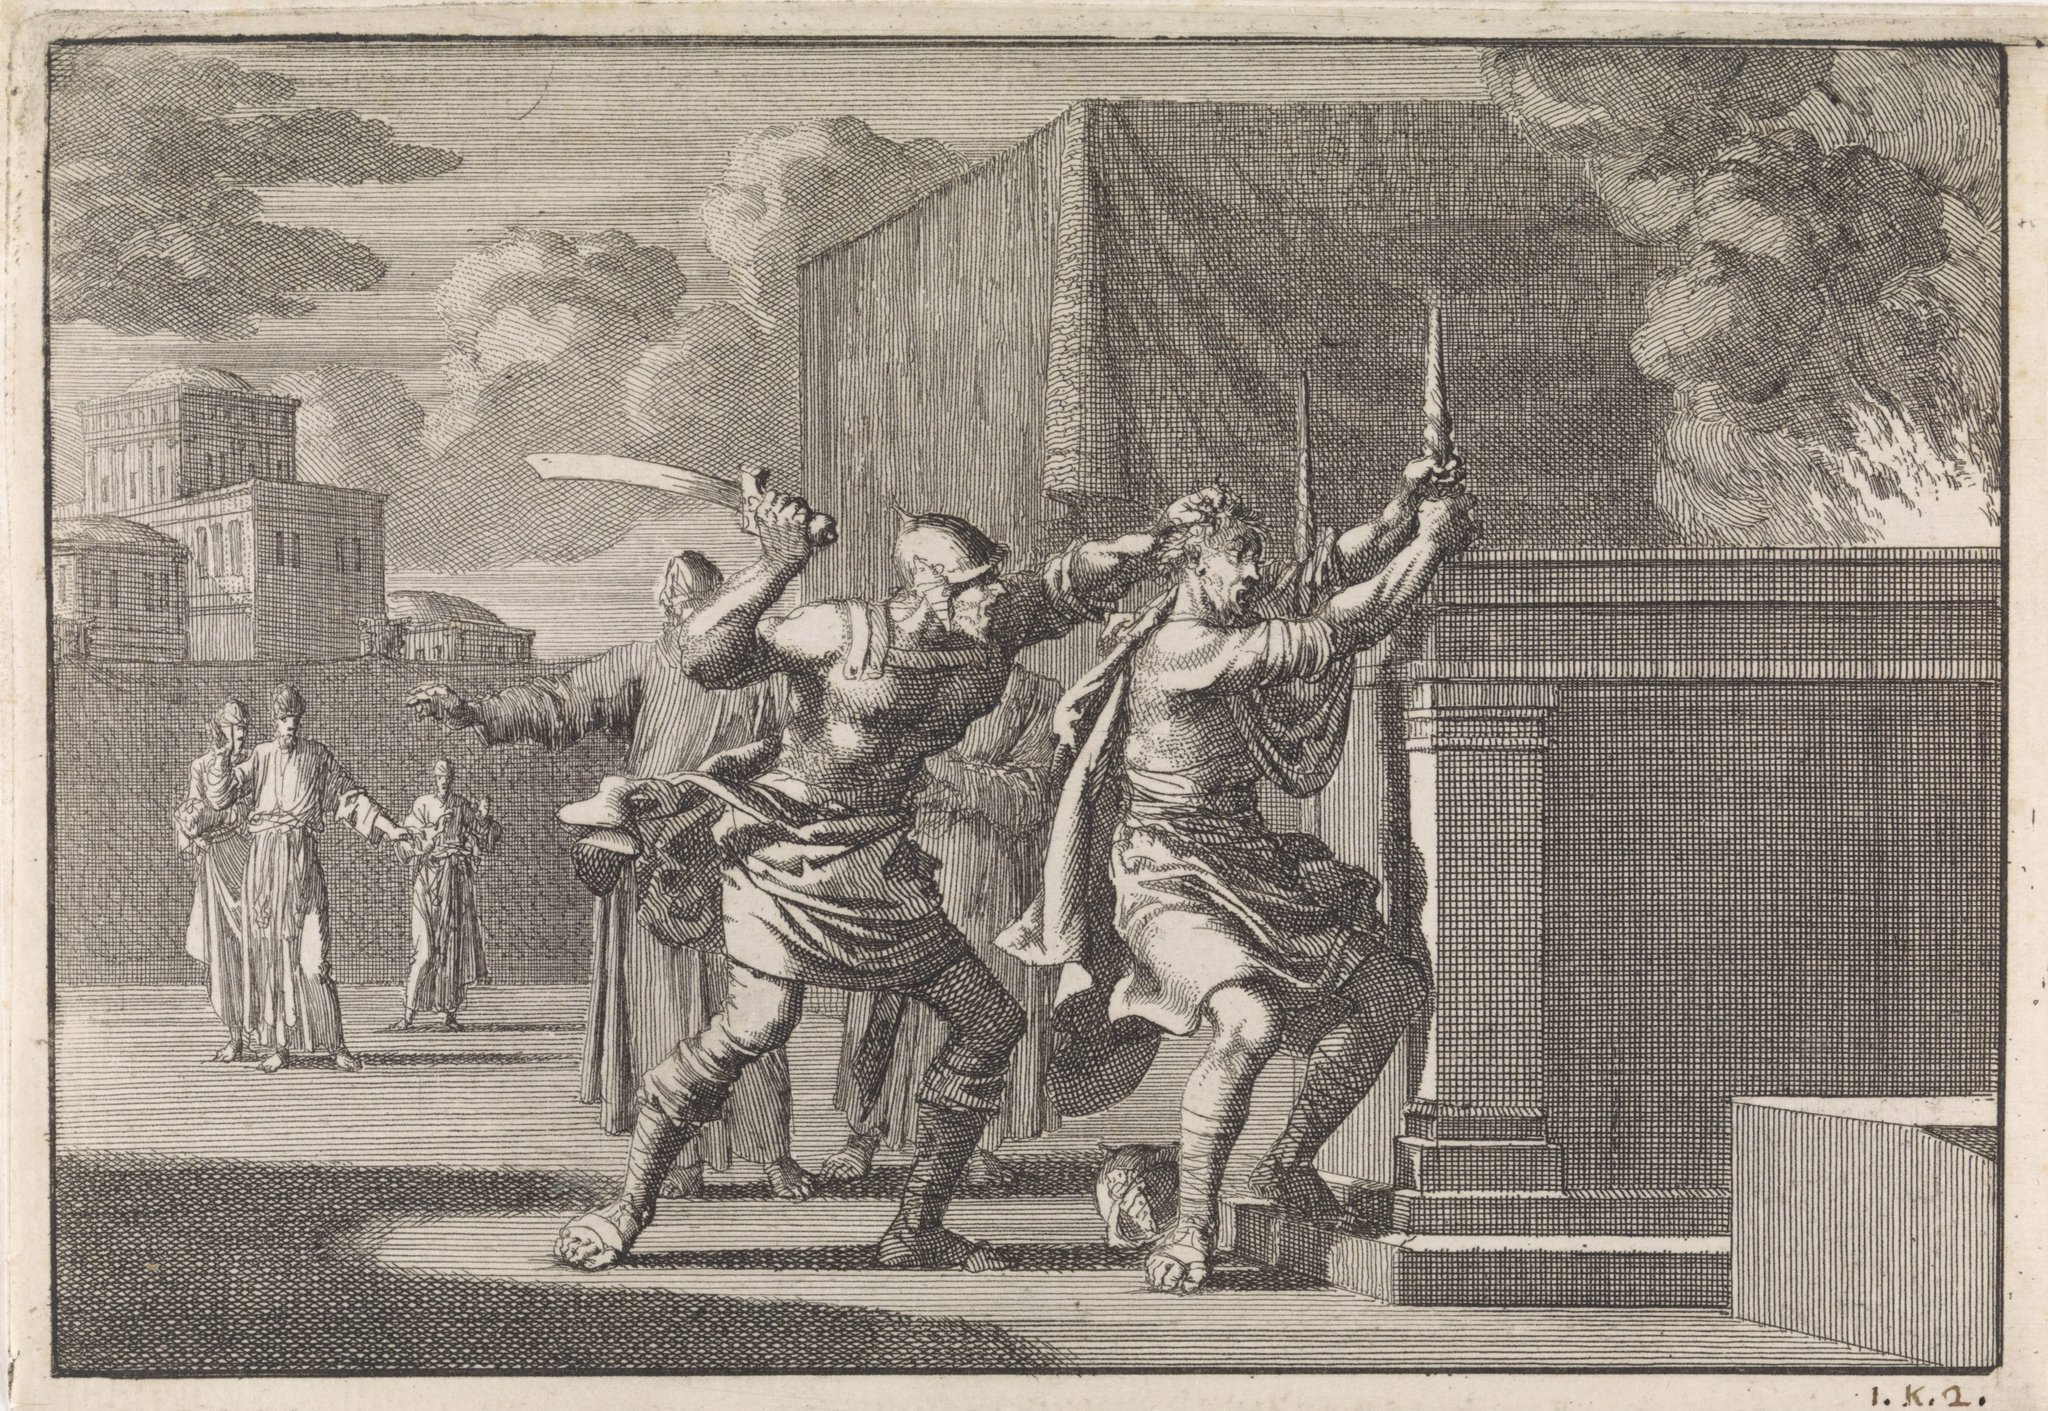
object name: print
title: Joab door Benaja gedood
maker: jan luyken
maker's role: draughtsman, print maker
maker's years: 1649-1712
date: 1704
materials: paper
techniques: etching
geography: amsterdam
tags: joab killed by benaiah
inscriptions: collector's mark: Lugt 2228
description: Prent ook gebruikt als boekillustratie in: Josephus, Flavius. Alle de Werken, 2 delen. Amsterdam: Pieter Mortier, 1704, dl. 1, p. 184.